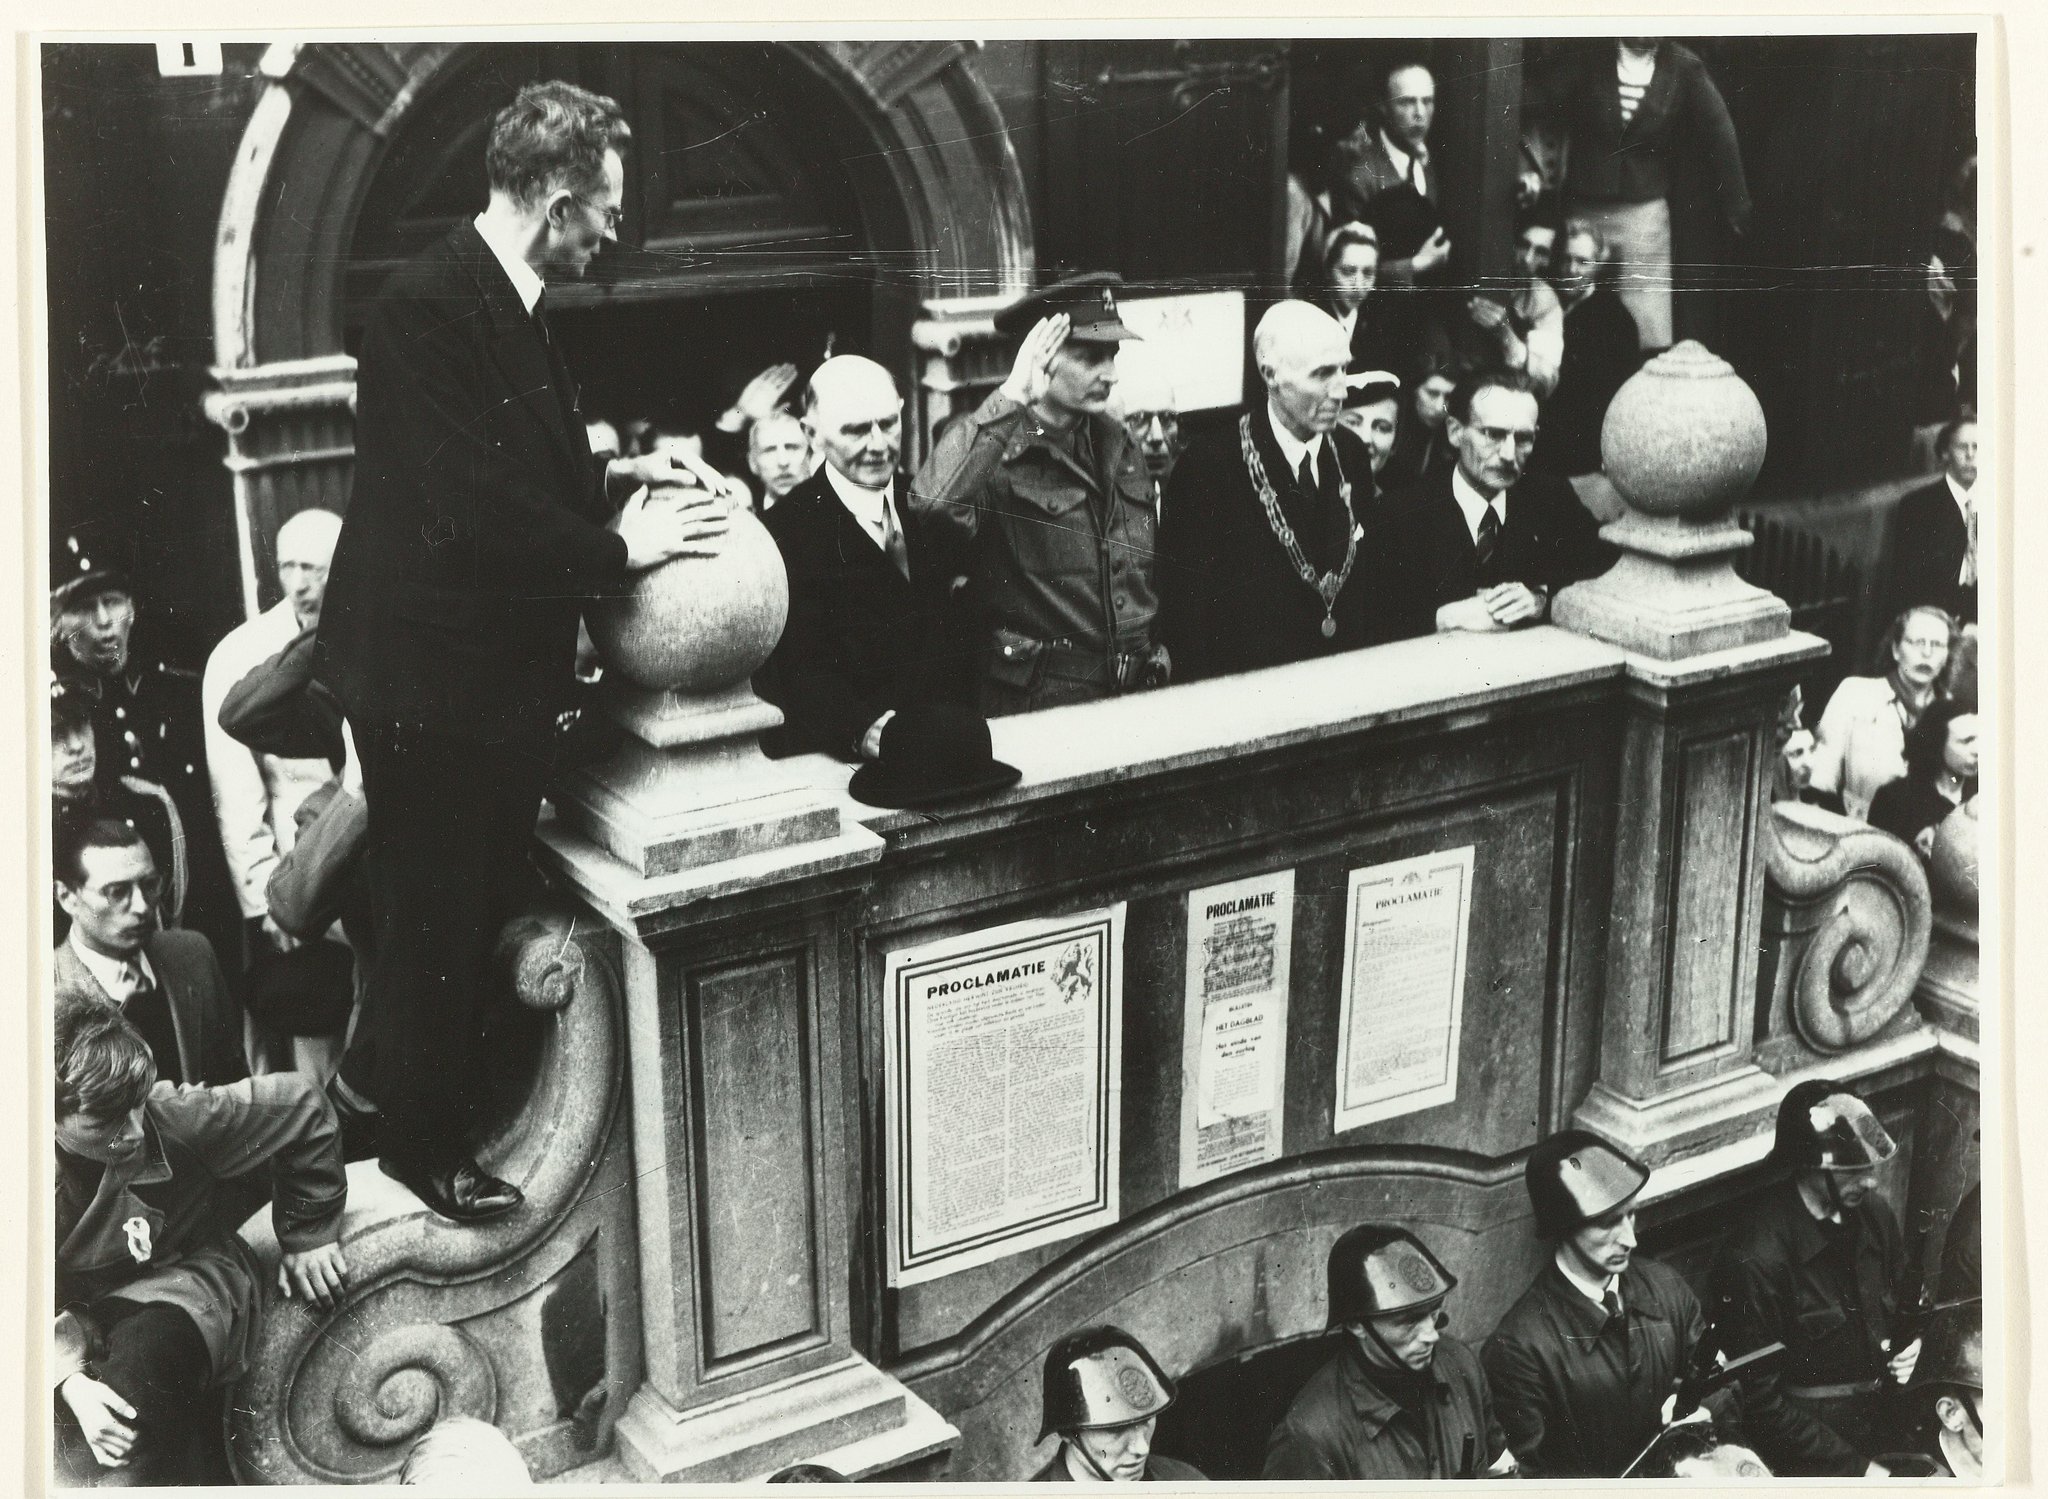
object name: documentary photograph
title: Willem Drees tijdens bevrijdingsfeest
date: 1945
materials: photographic support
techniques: photography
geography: the hague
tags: de monchy, amsterdam, the hague, willem drees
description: Willem Drees staat met burgemeester de Monchy op een bordes tijdens een bevrijdingsfestiviteit in Den Haag.